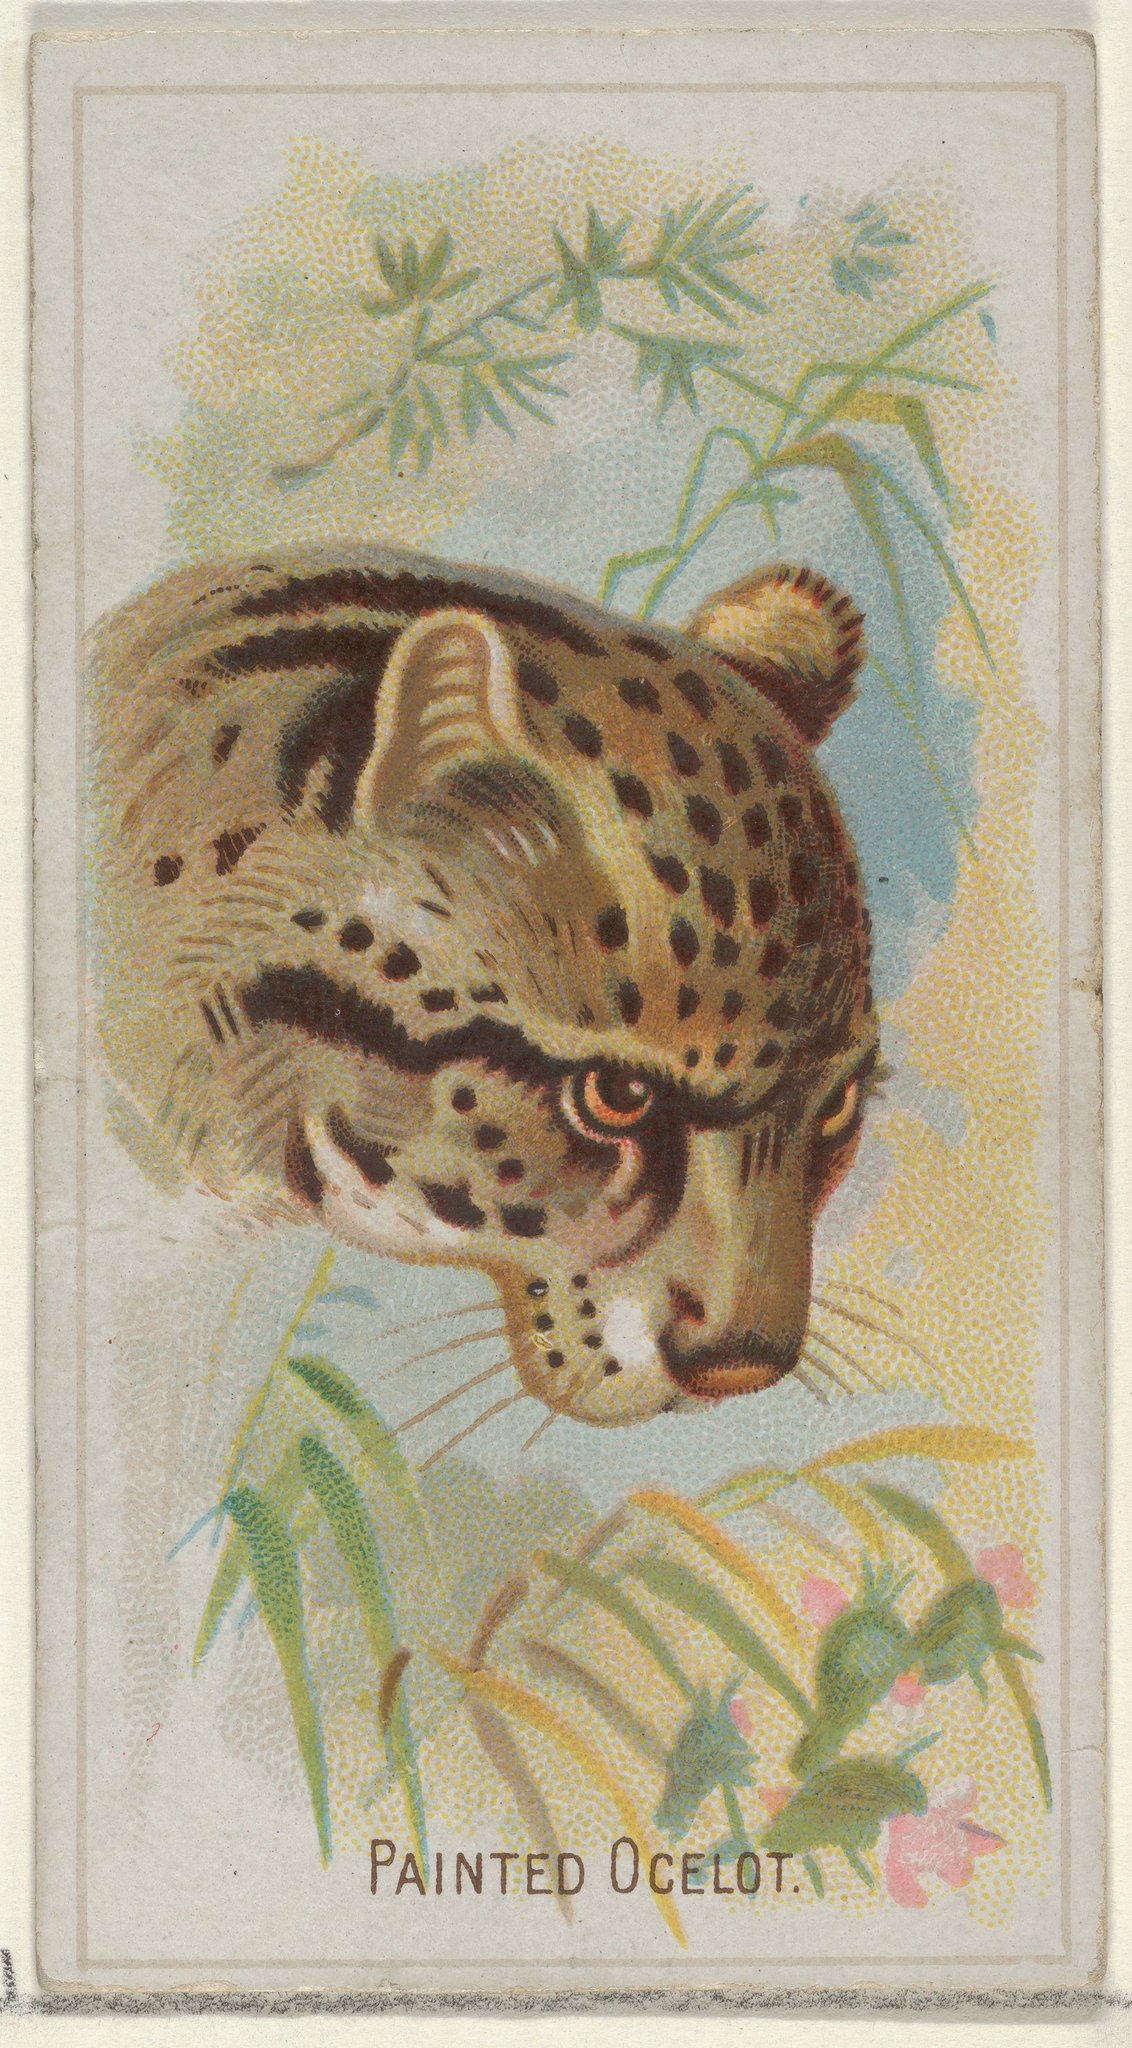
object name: print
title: Painted Ocelot, from the Wild Animals of the World series (N25) for Allen & Ginter Cigarettes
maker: allen & ginter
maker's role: publisher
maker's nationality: american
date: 1888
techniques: color lithograph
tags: animals